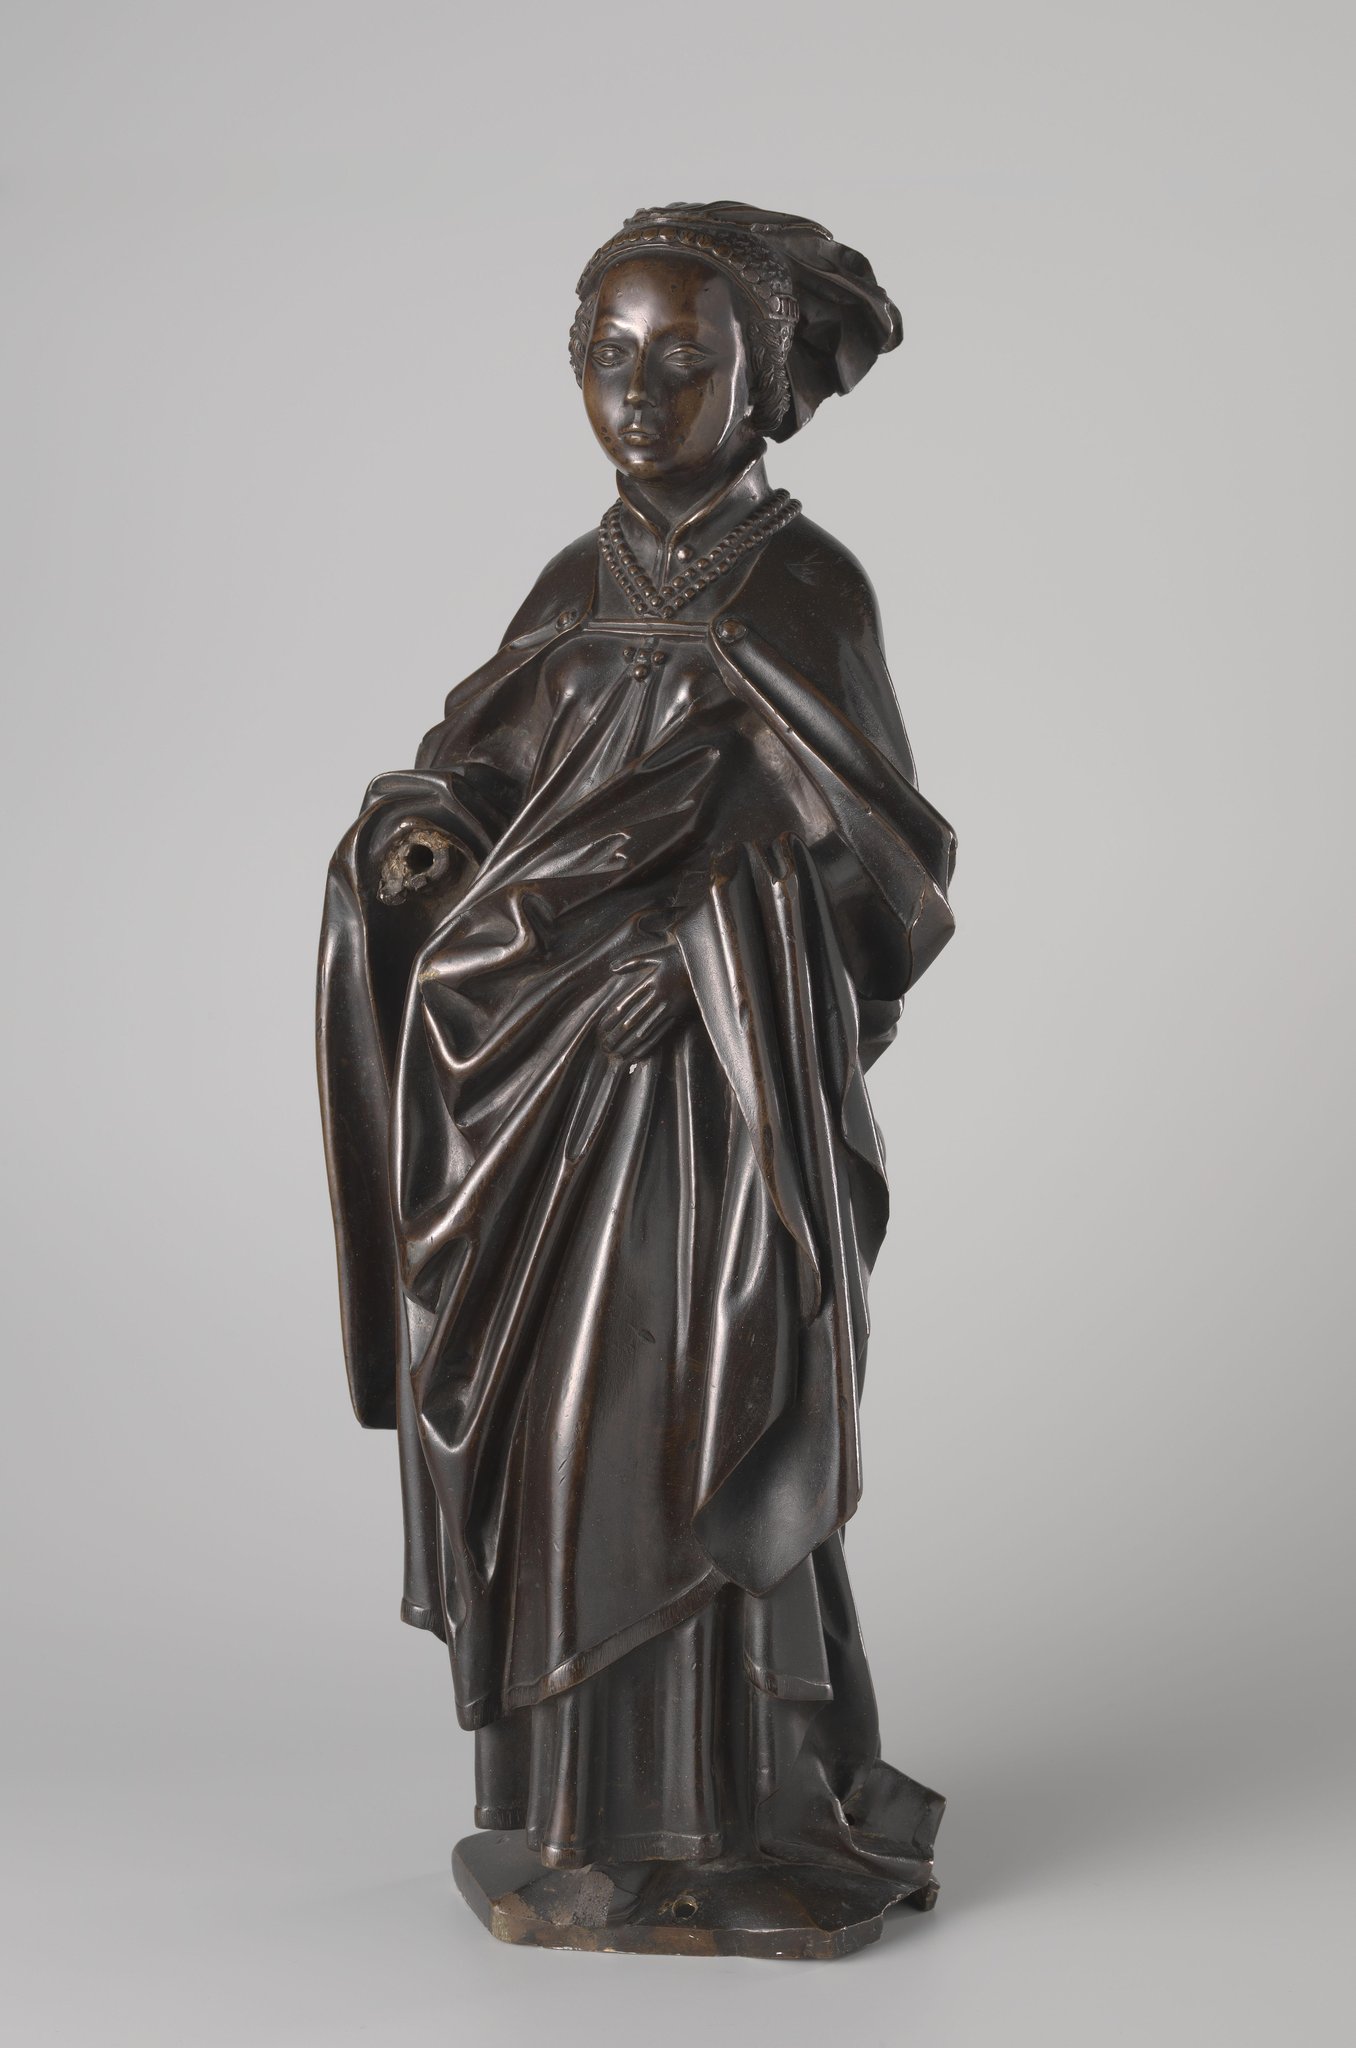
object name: tomb figure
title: Isabella van Bourbon & Pleurants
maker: renier van thienen (i)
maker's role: brazier, caster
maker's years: 1465-1498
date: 1475-1476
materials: bronze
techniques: casting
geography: brussels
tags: antwerp, 'pleurants', clothes, costume (+ women's clothes), bracelet, wristlet (+ women's clothes), necklace (+ women's clothes), nobility and patriciate; chivalry, knighthood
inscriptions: inscription, on the back, at the bottom, incised after casting and finishing: indistinguishable location mark, number, on the back, at the top, in modern white paint: ‘10’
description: Mary of Burgundy had a mausoleum erected for her late mother, Isabella of Bourbon. Only the gisant (tomb effigy) of Isabella and 10 of the 24 figures originally surrounding the tomb have been preserved. These pleurants (weepers) represent five generations of grieving forebears. While the tomb commemorated Isabella, it mainly served to advertise Mary’s noble lineage. She was the sole remaining heir of the Dukes of Burgundy and therefore a highly desirable consort. A year after the monument was completed, she married Maximilian of Habsburg, whereby the Burgundian Netherlands became part of the vast Holy Roman Empire.